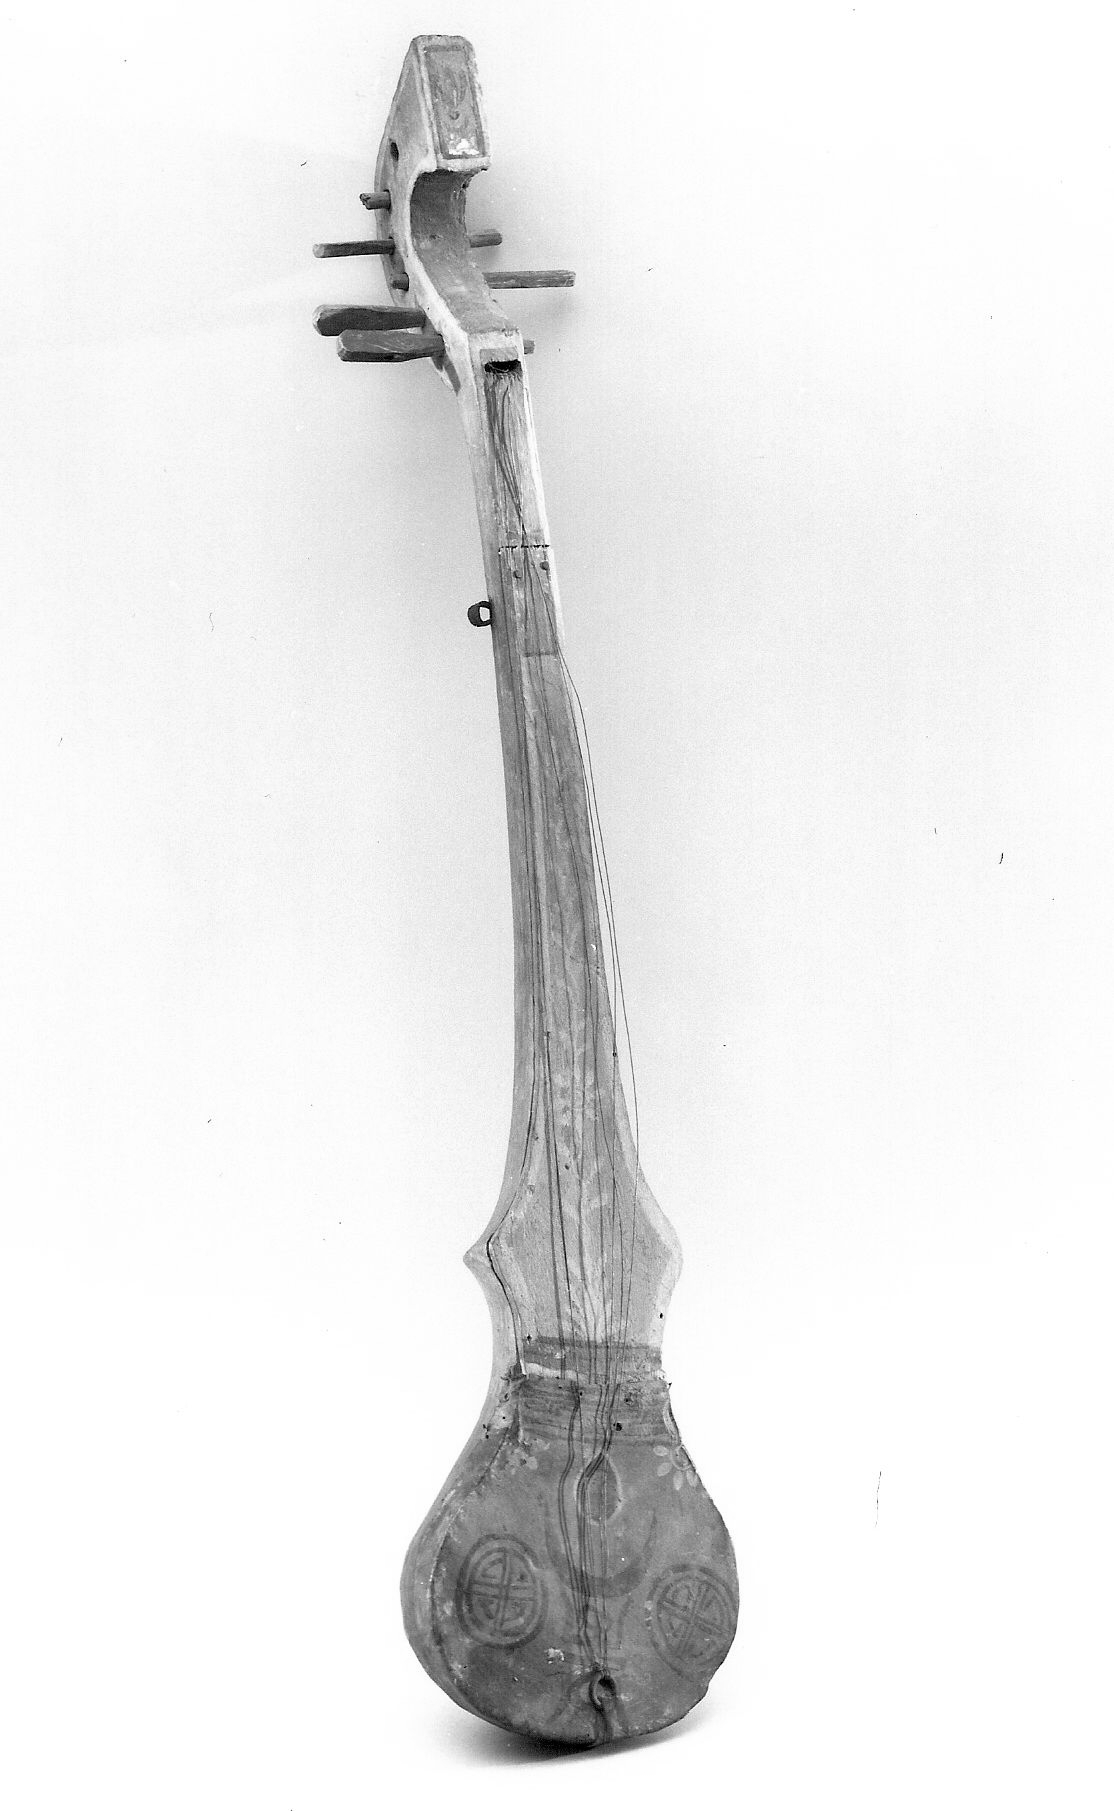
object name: sgra snyan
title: Sgra-Snyan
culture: tibetan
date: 1867-1900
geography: tibet